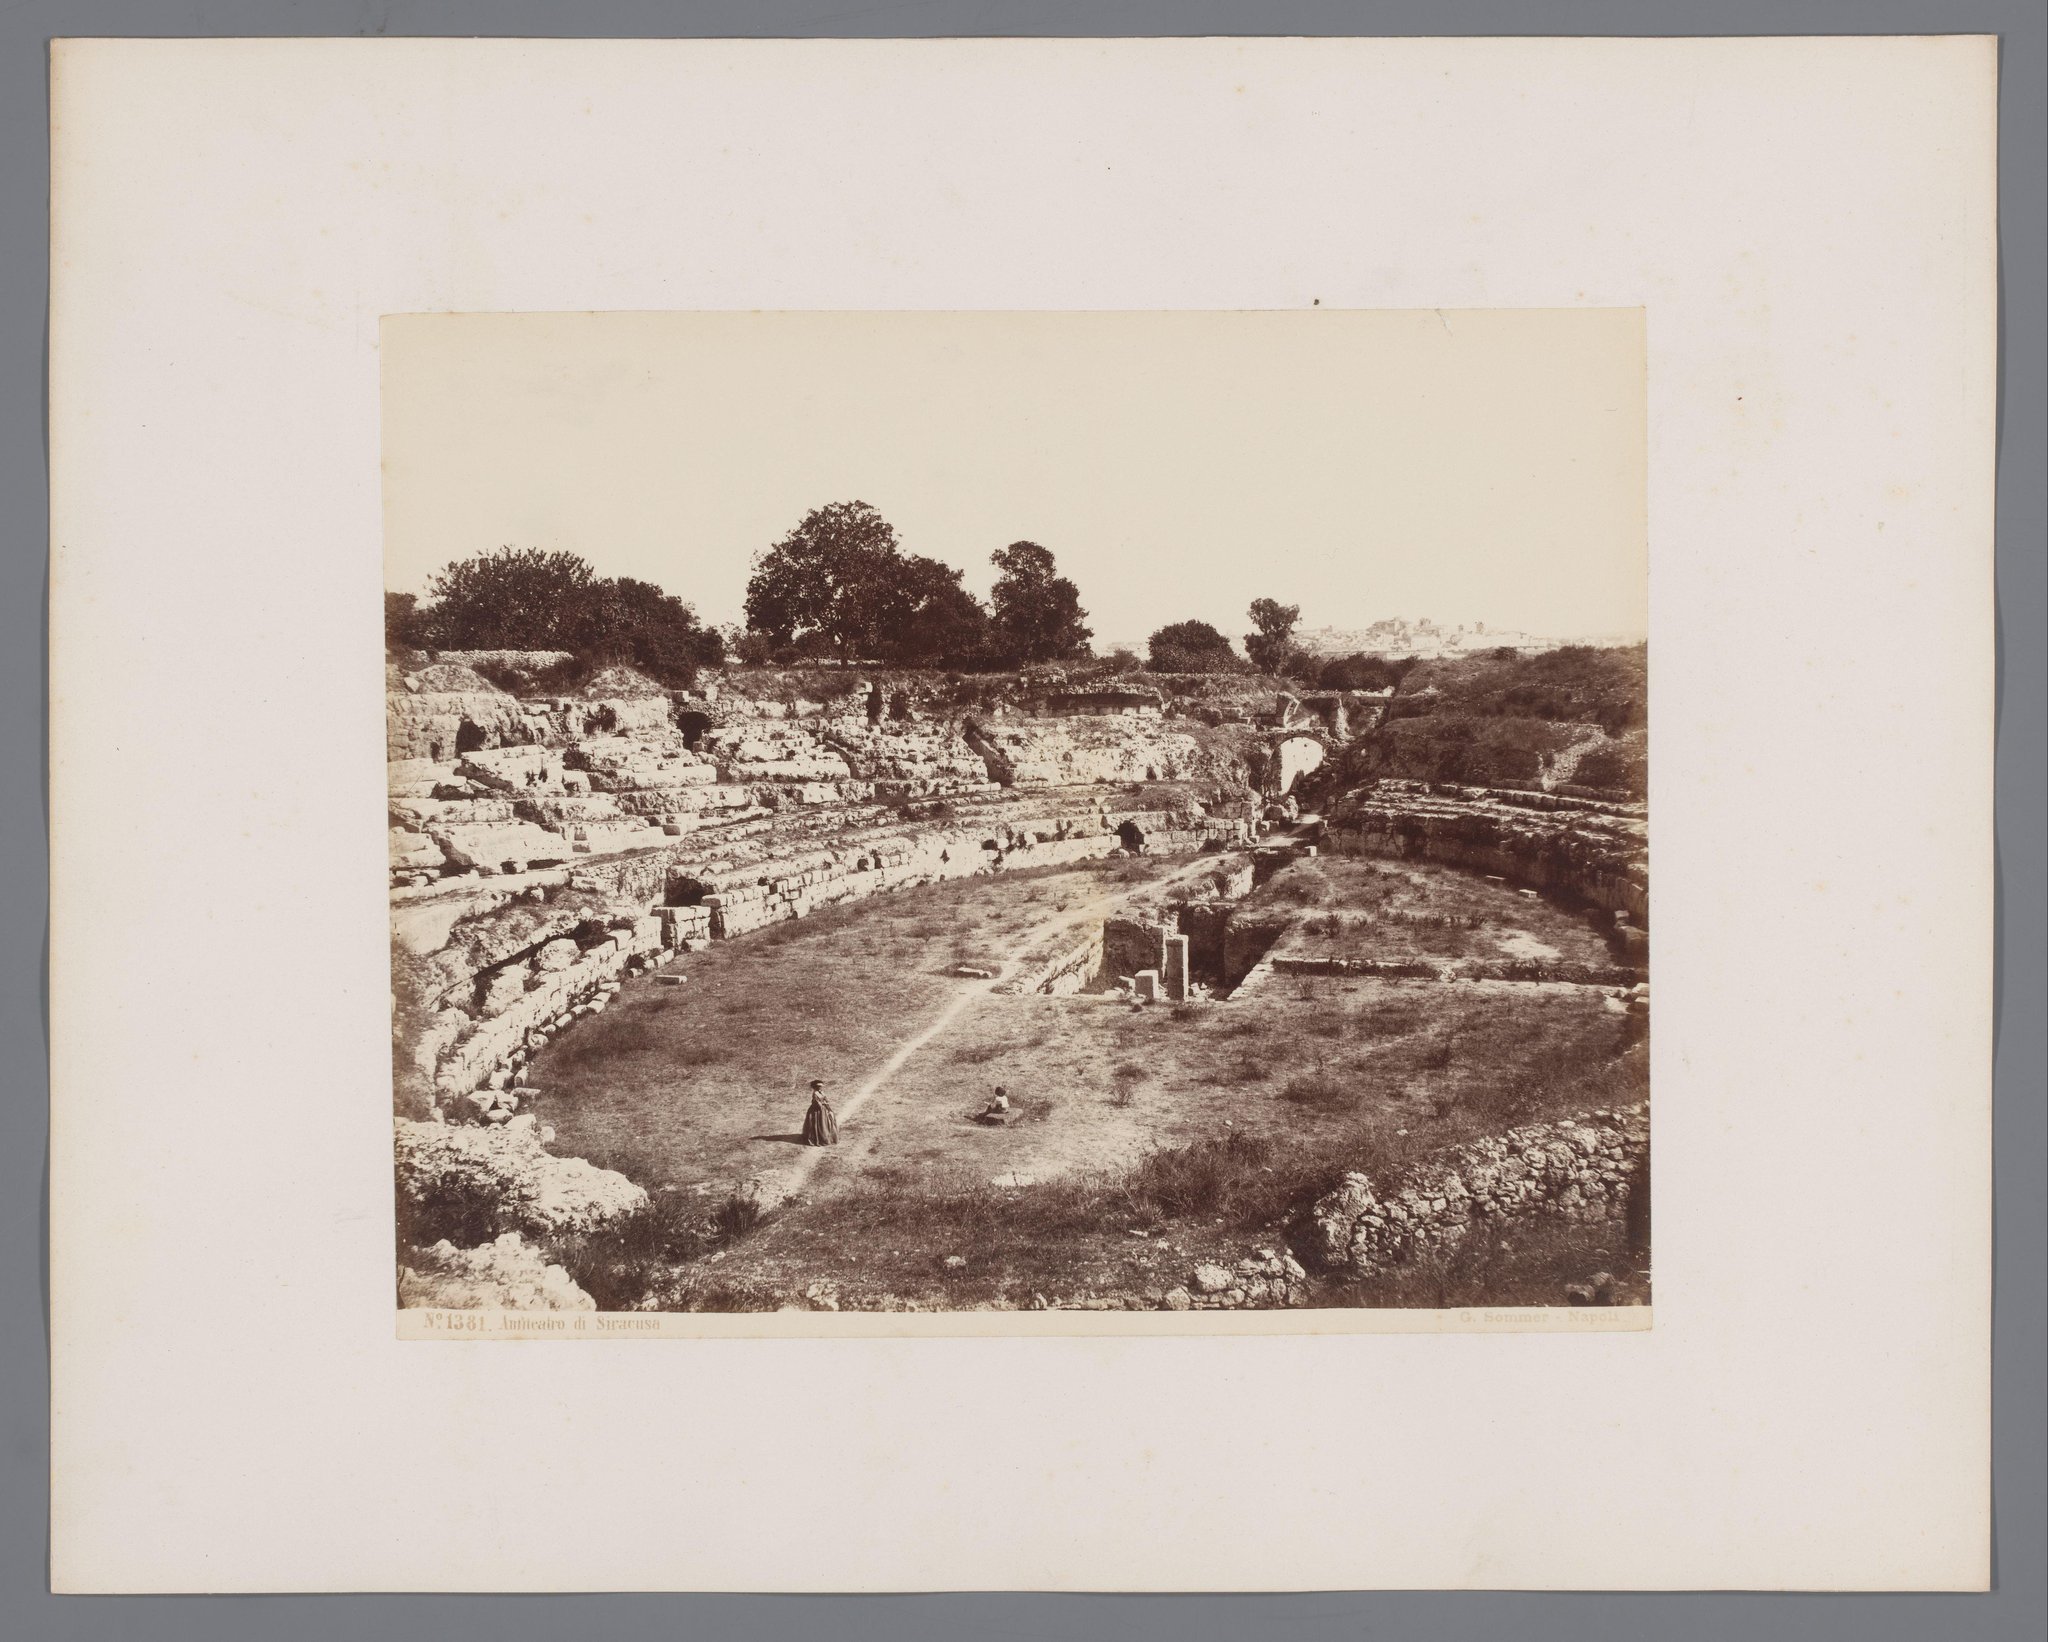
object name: photograph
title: Gezicht op de ruïnes van een amfitheater in Syracuse, Sicilië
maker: giorgio sommer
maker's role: fotograaf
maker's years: 1834-1914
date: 1857-1914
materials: cardboard, paper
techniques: albumen print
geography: syracuse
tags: ruin of a building ~ architecture, amphitheatre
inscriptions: number: ‘No. 1381.’